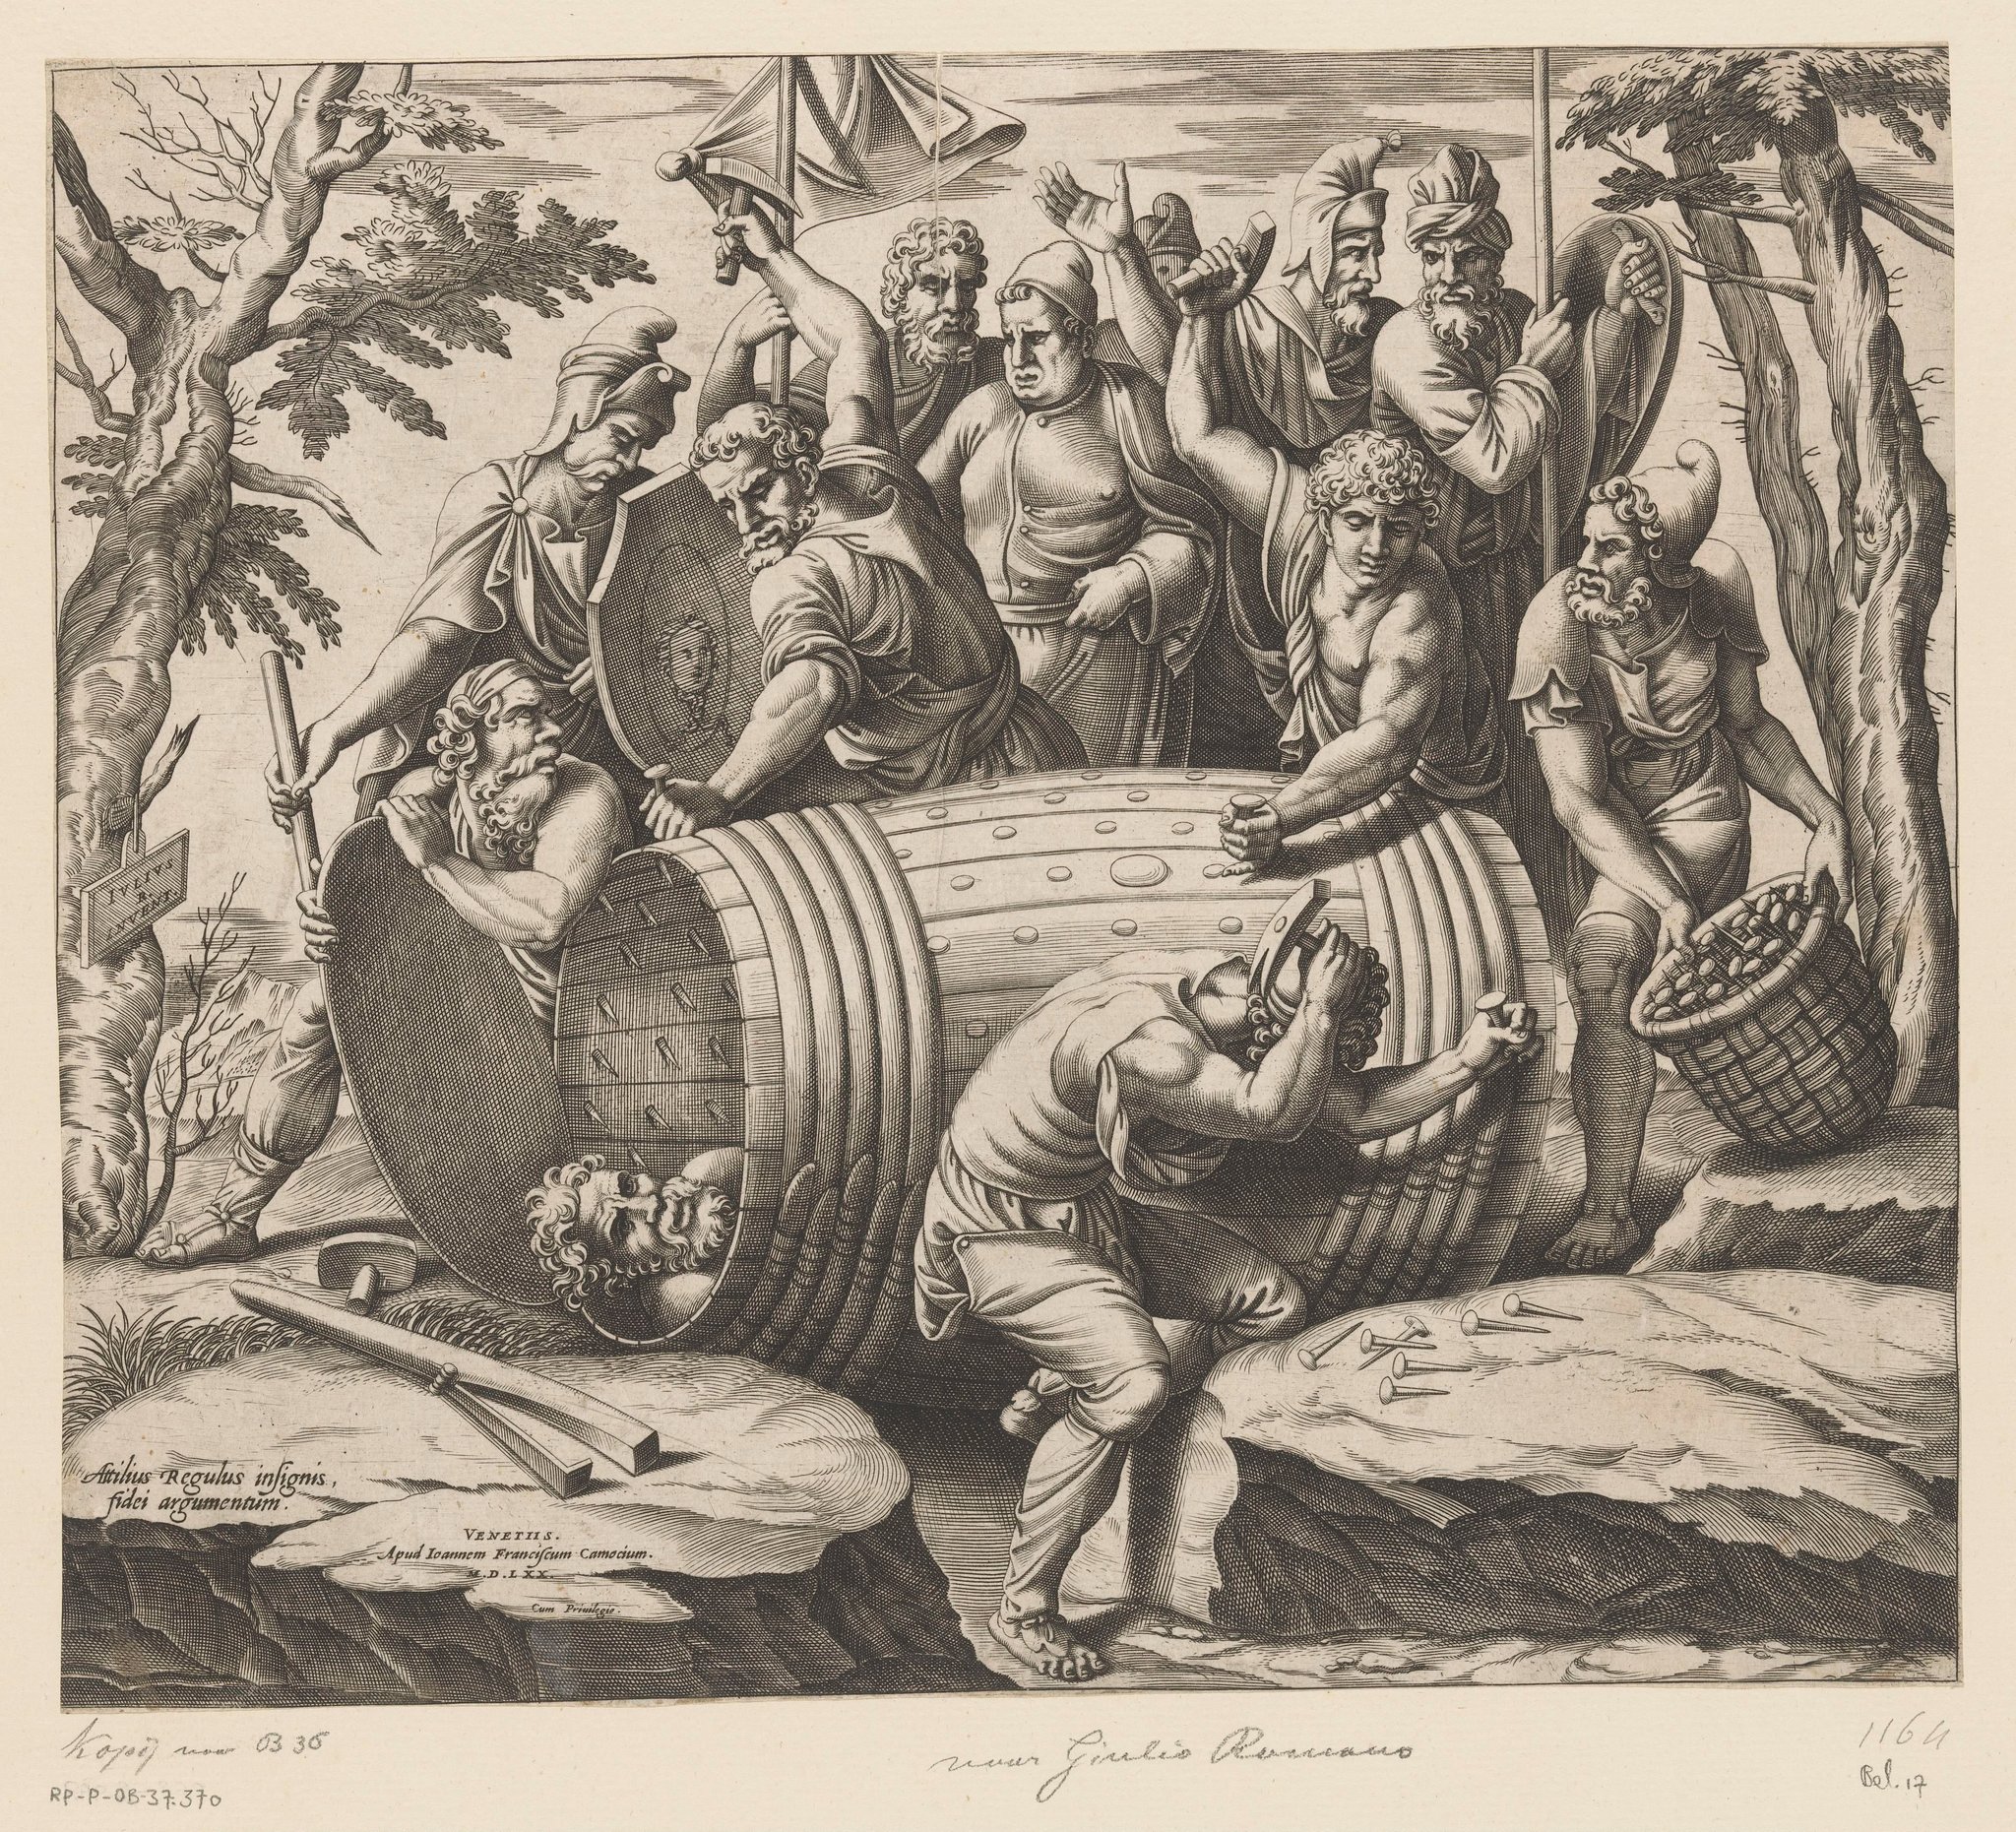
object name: print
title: Marteldood van Marcus Atilius Regulus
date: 1570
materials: paper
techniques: engraving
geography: venice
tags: death of regulus: he is enclosed in a nail-studded barrel by the carthaginians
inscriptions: collector's mark: Lugt 240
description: Door Bartsch wordt deze prent aangeduid als kopie naar een prent van Diana Mantuana, naar een muurschildering ontworpen door Giulio Romano. Volgens Bellini werd deze prent echter niet vervaardigd naar voorbeeld van Mantuana's prent, maar direct naar de door Giulio Romano ontworpen muurschildering.